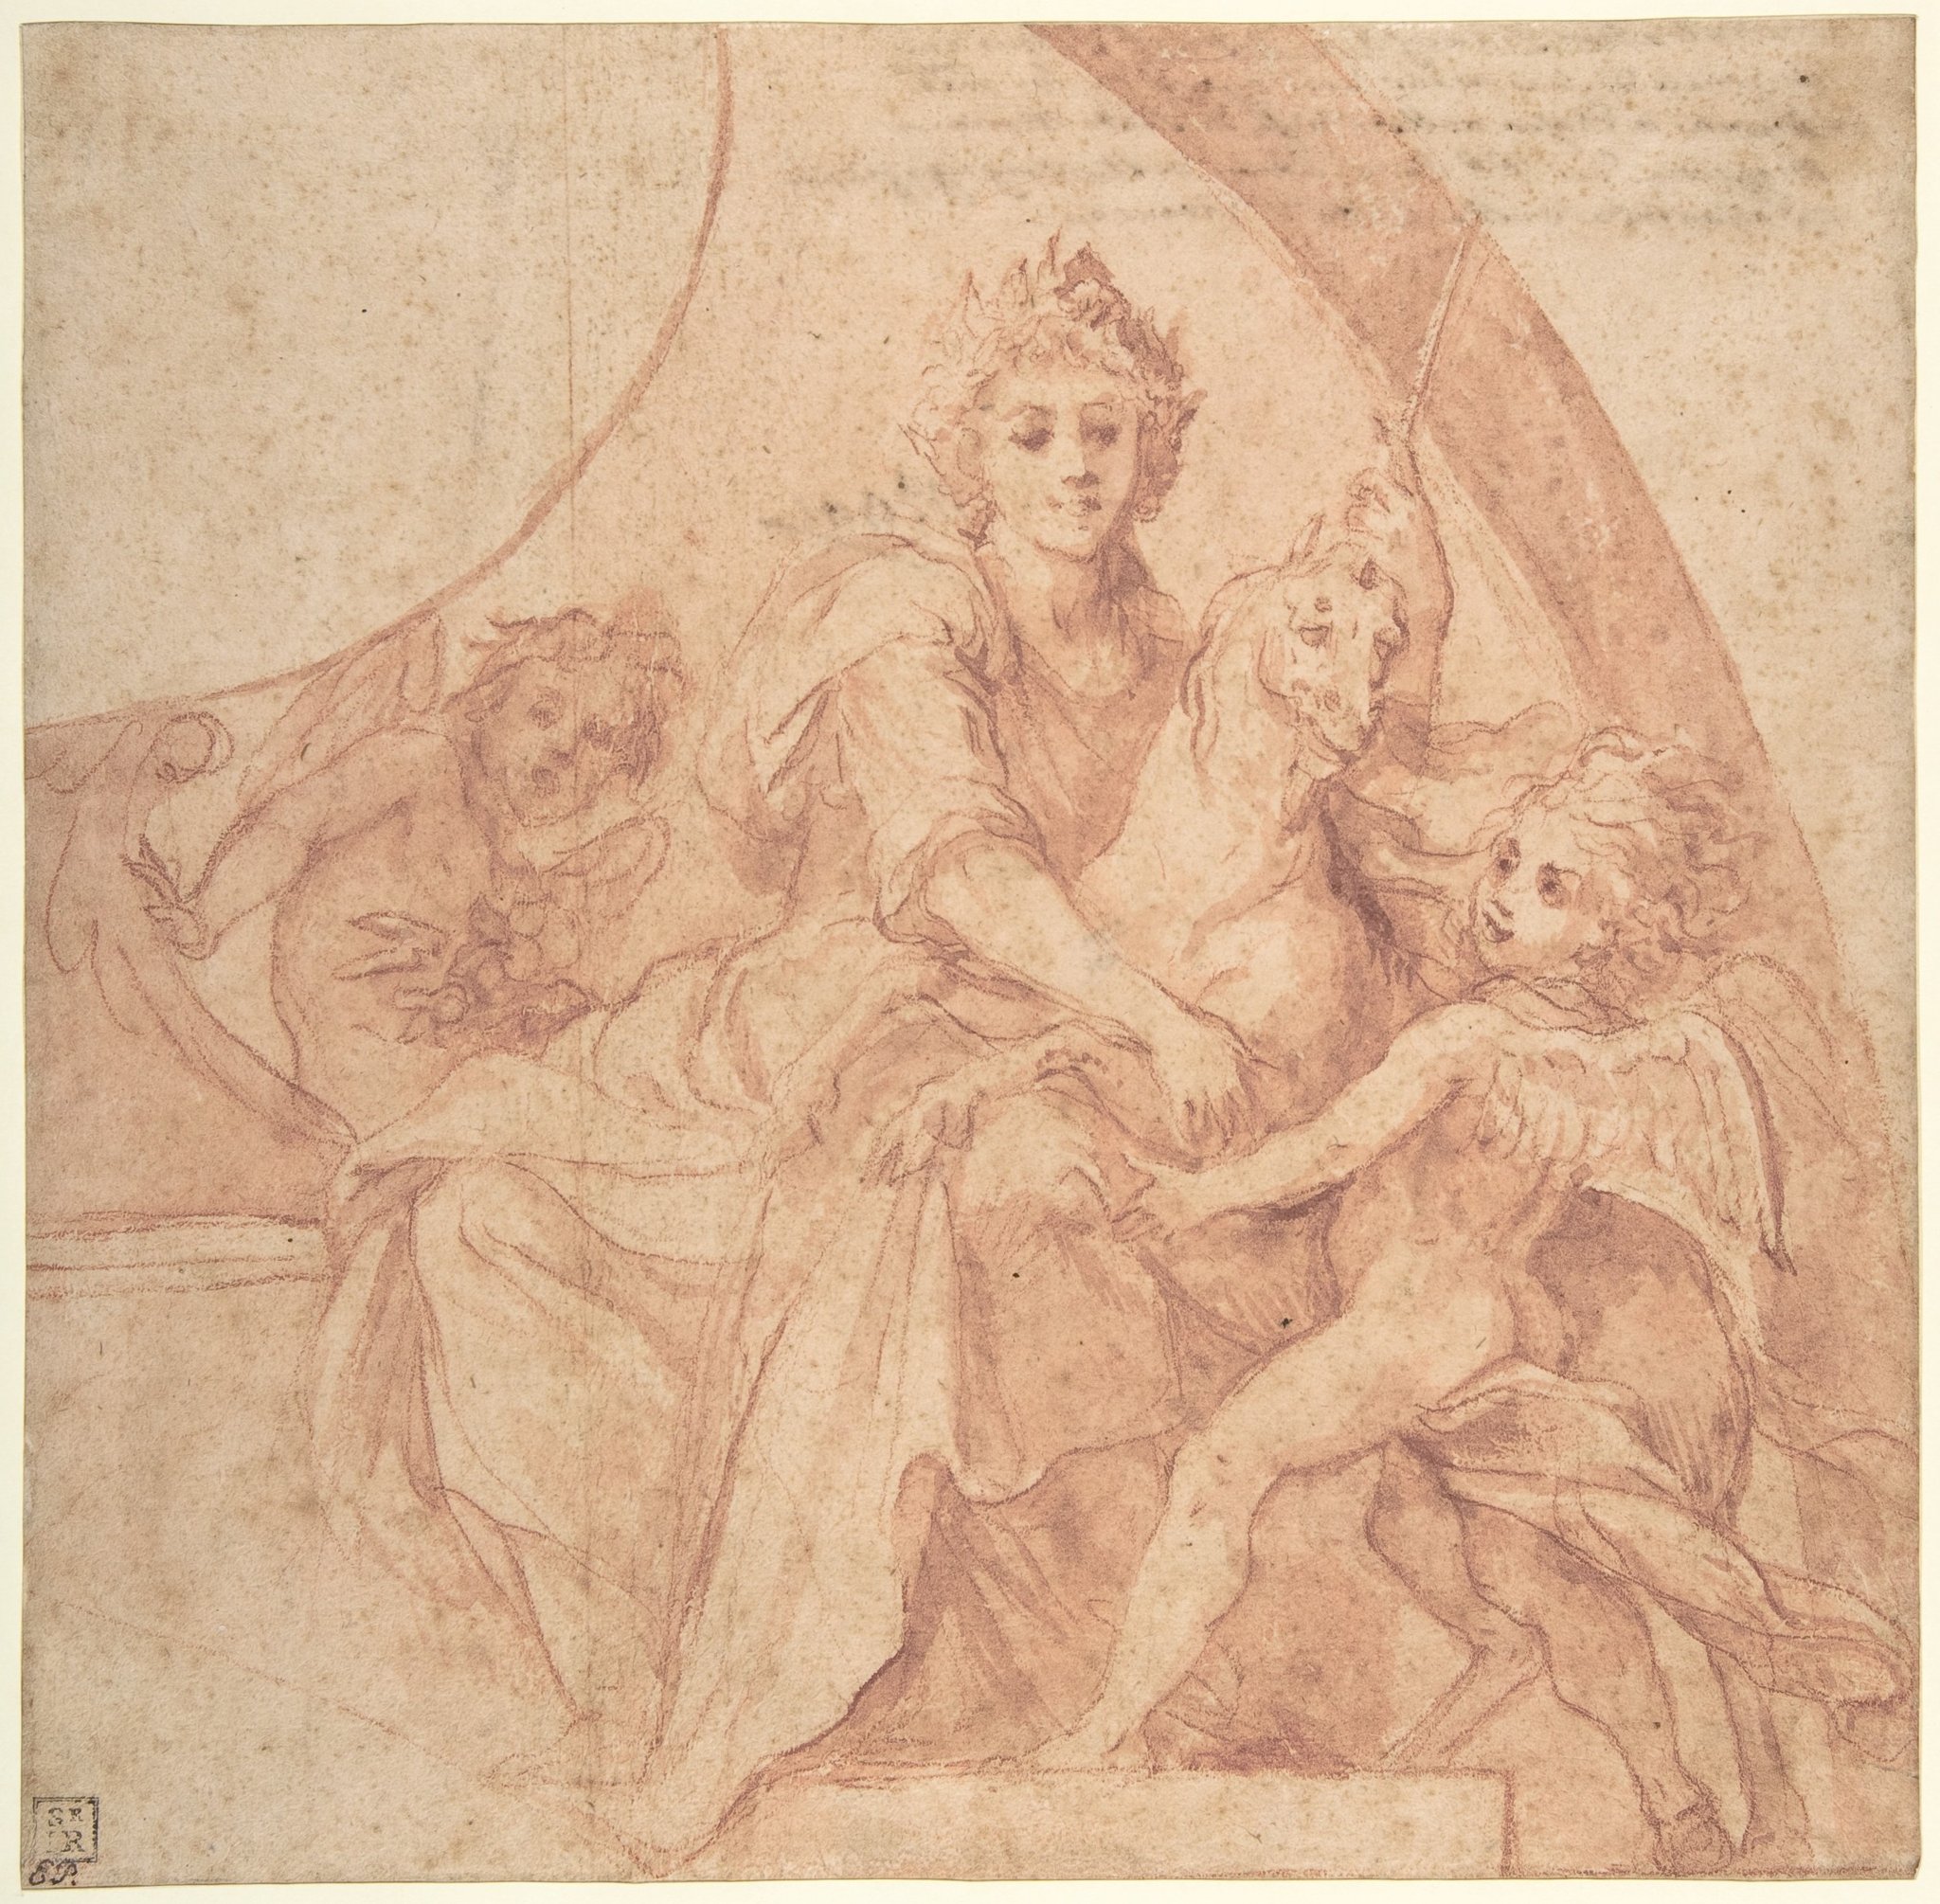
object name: drawing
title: Allegorical Figure of Purity with a Unicorn and Two Putti (recto); Study of the Same Figures (verso)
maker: baldassarre franceschini (il volterrano)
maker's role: artist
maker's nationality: italian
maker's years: 1611-1690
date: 1642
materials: chalk, paper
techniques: brush, wash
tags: women,unicorns,putti